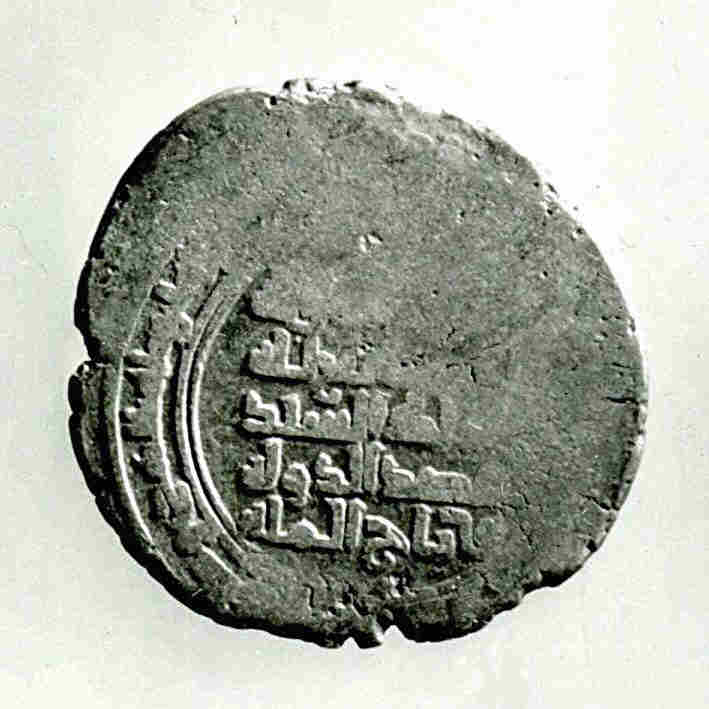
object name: coin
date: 977-982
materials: silver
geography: iran